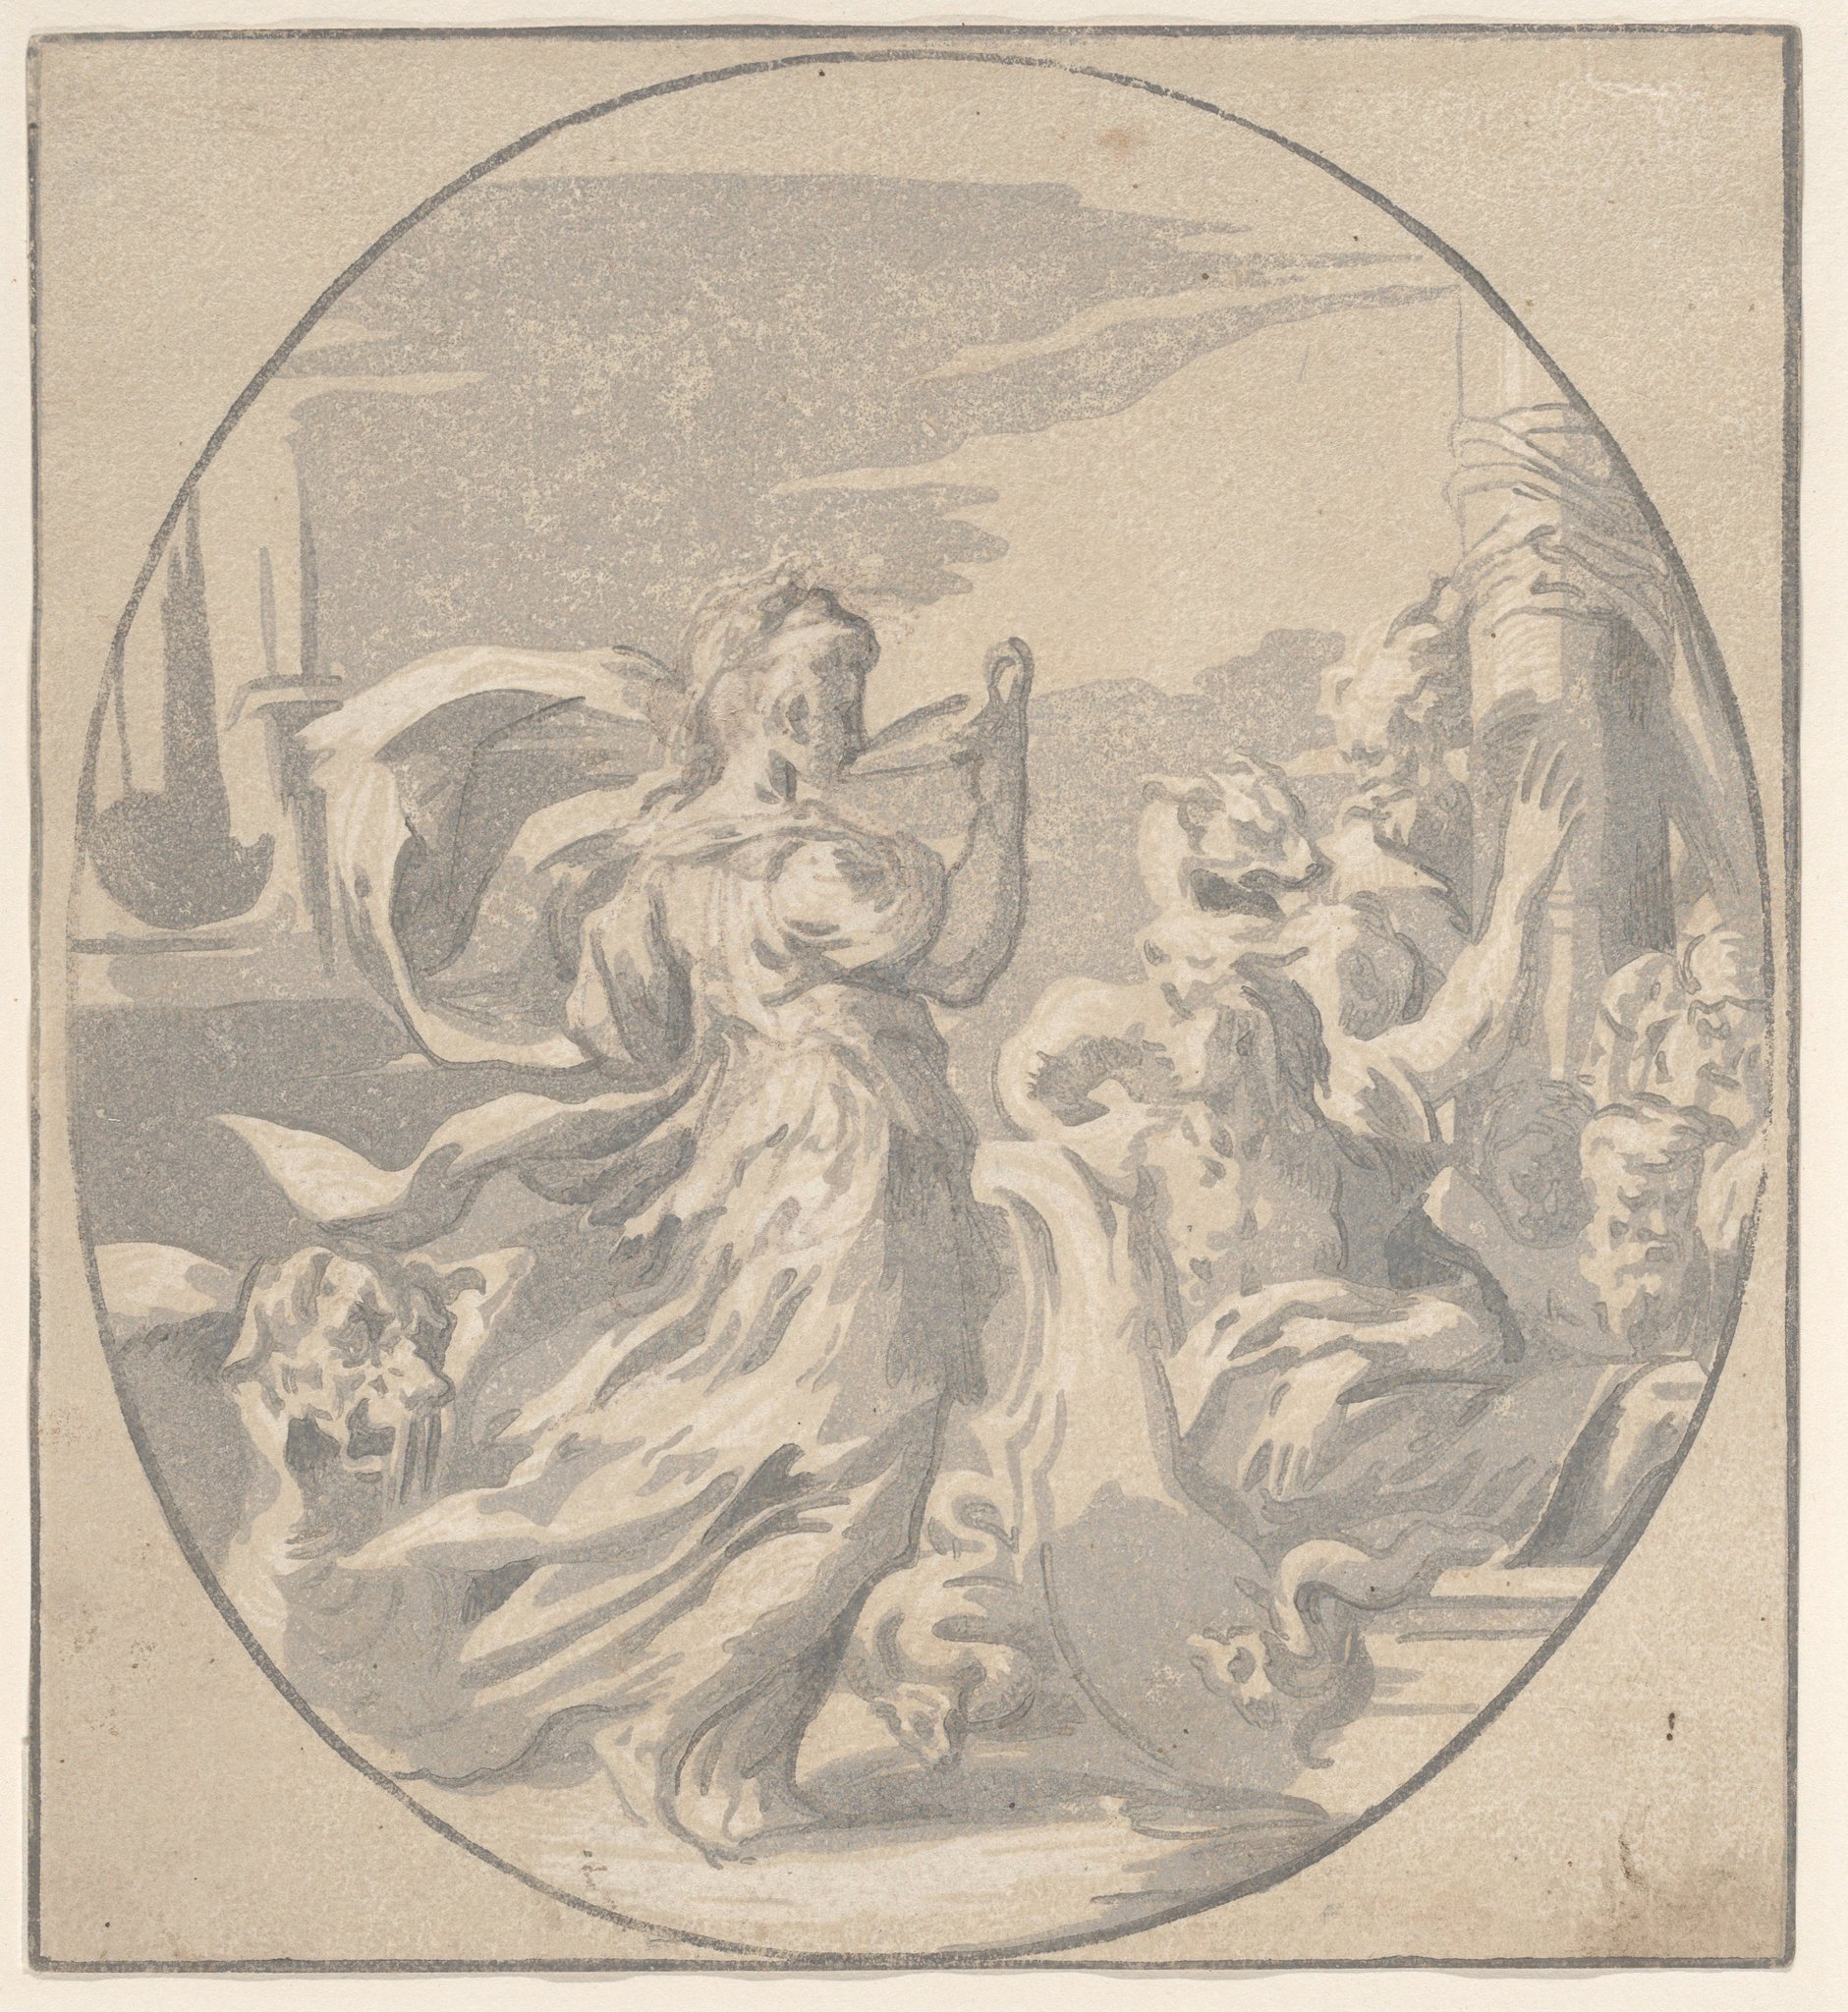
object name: print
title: Circe drinking from a cup, an oval composition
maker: niccolò vicentino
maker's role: artist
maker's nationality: italian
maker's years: 1510-1550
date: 1540-1550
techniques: woodcut